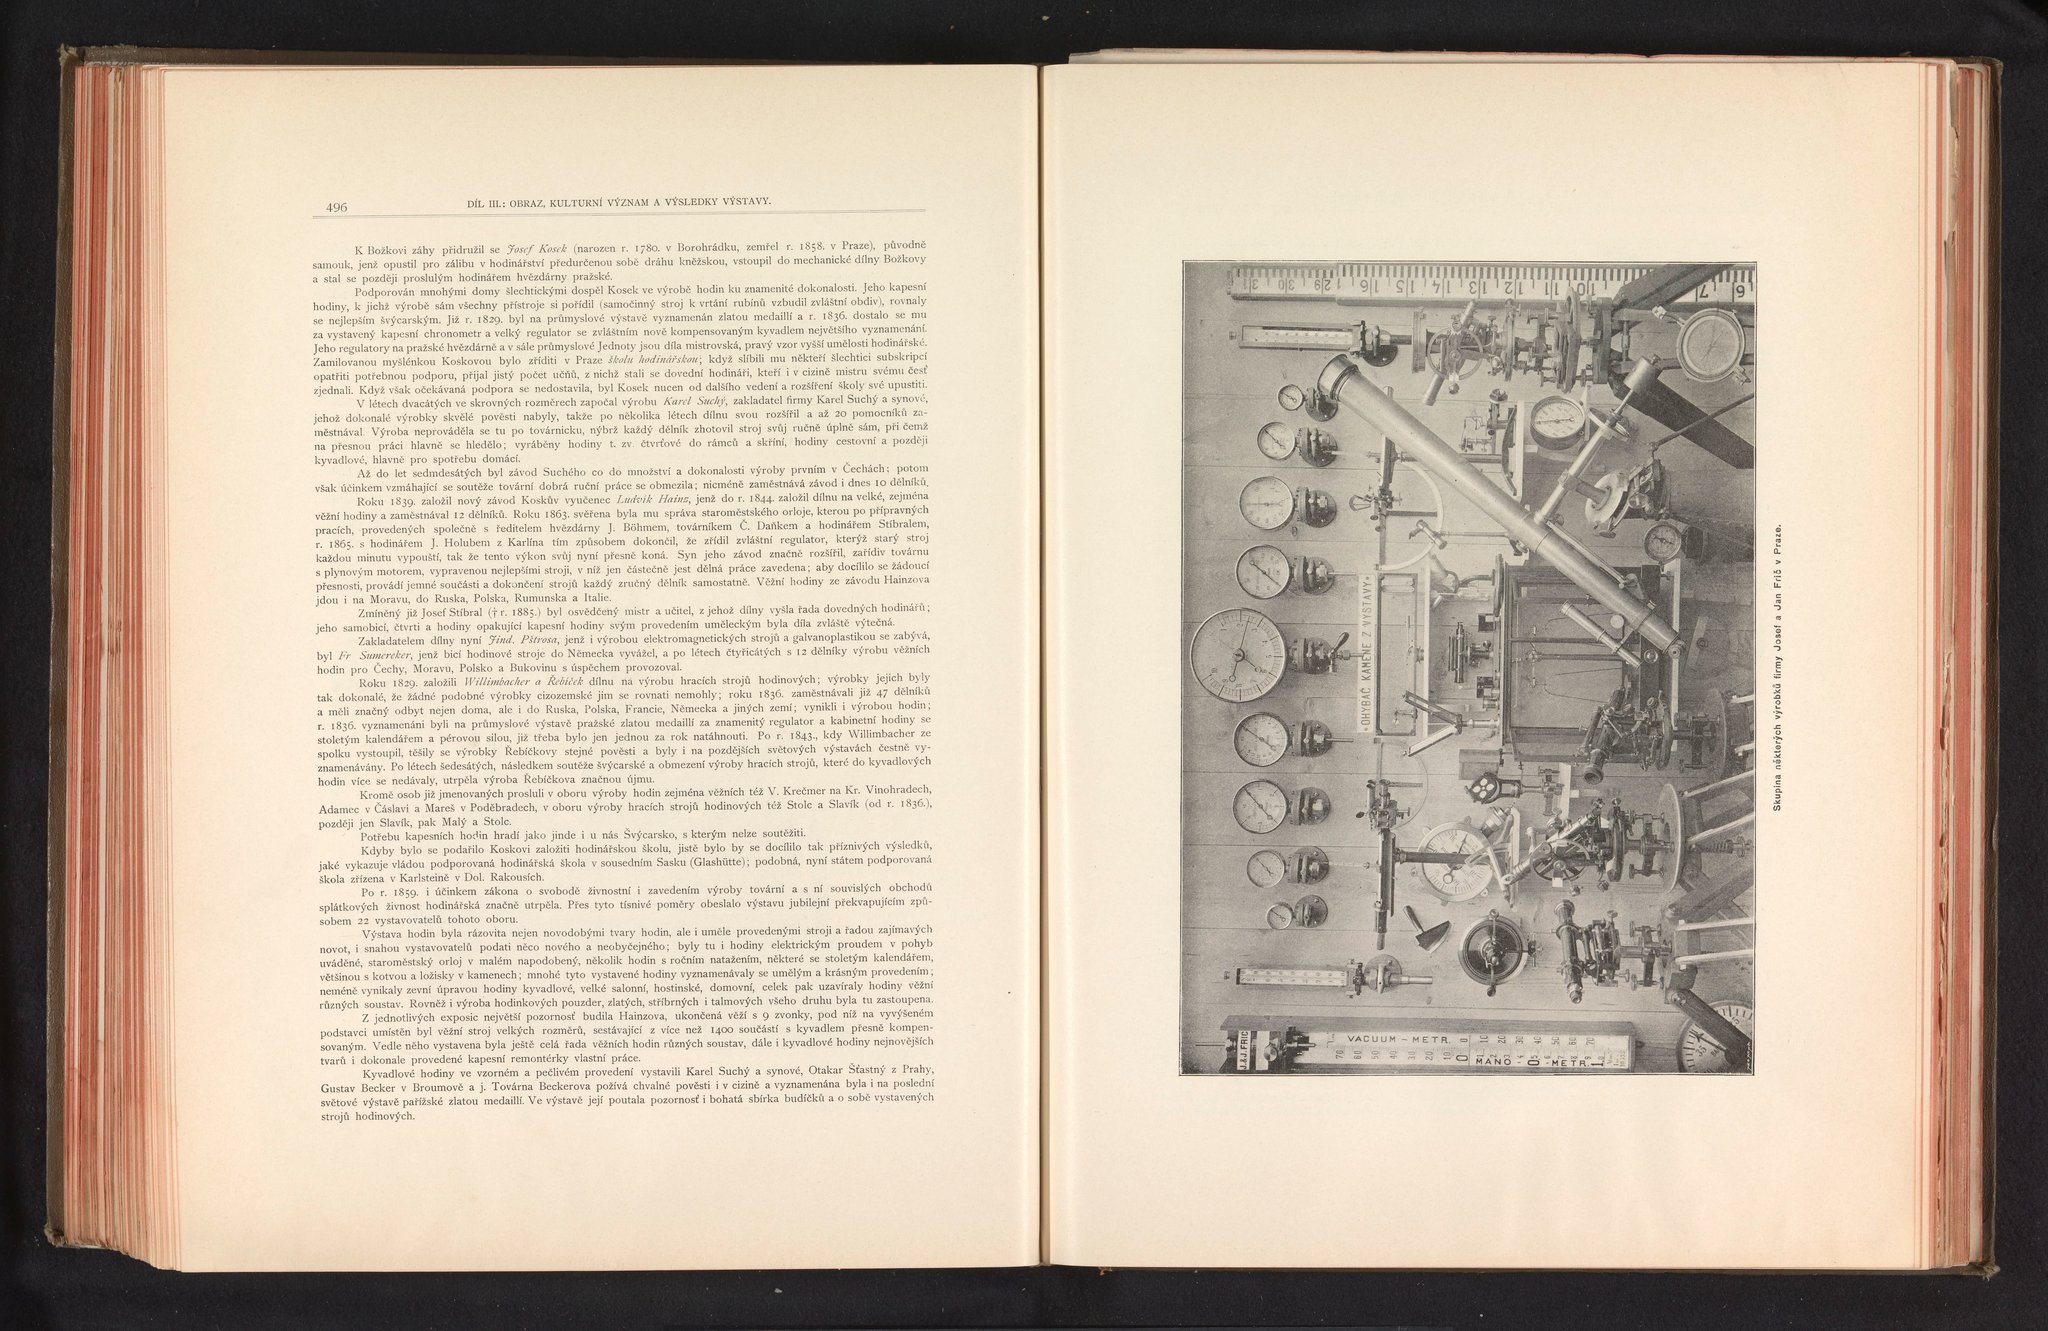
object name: page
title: Telescopen en meters van Josef en Jan Fric te Praag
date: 1891-1895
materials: paper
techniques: autotype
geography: prague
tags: telescope